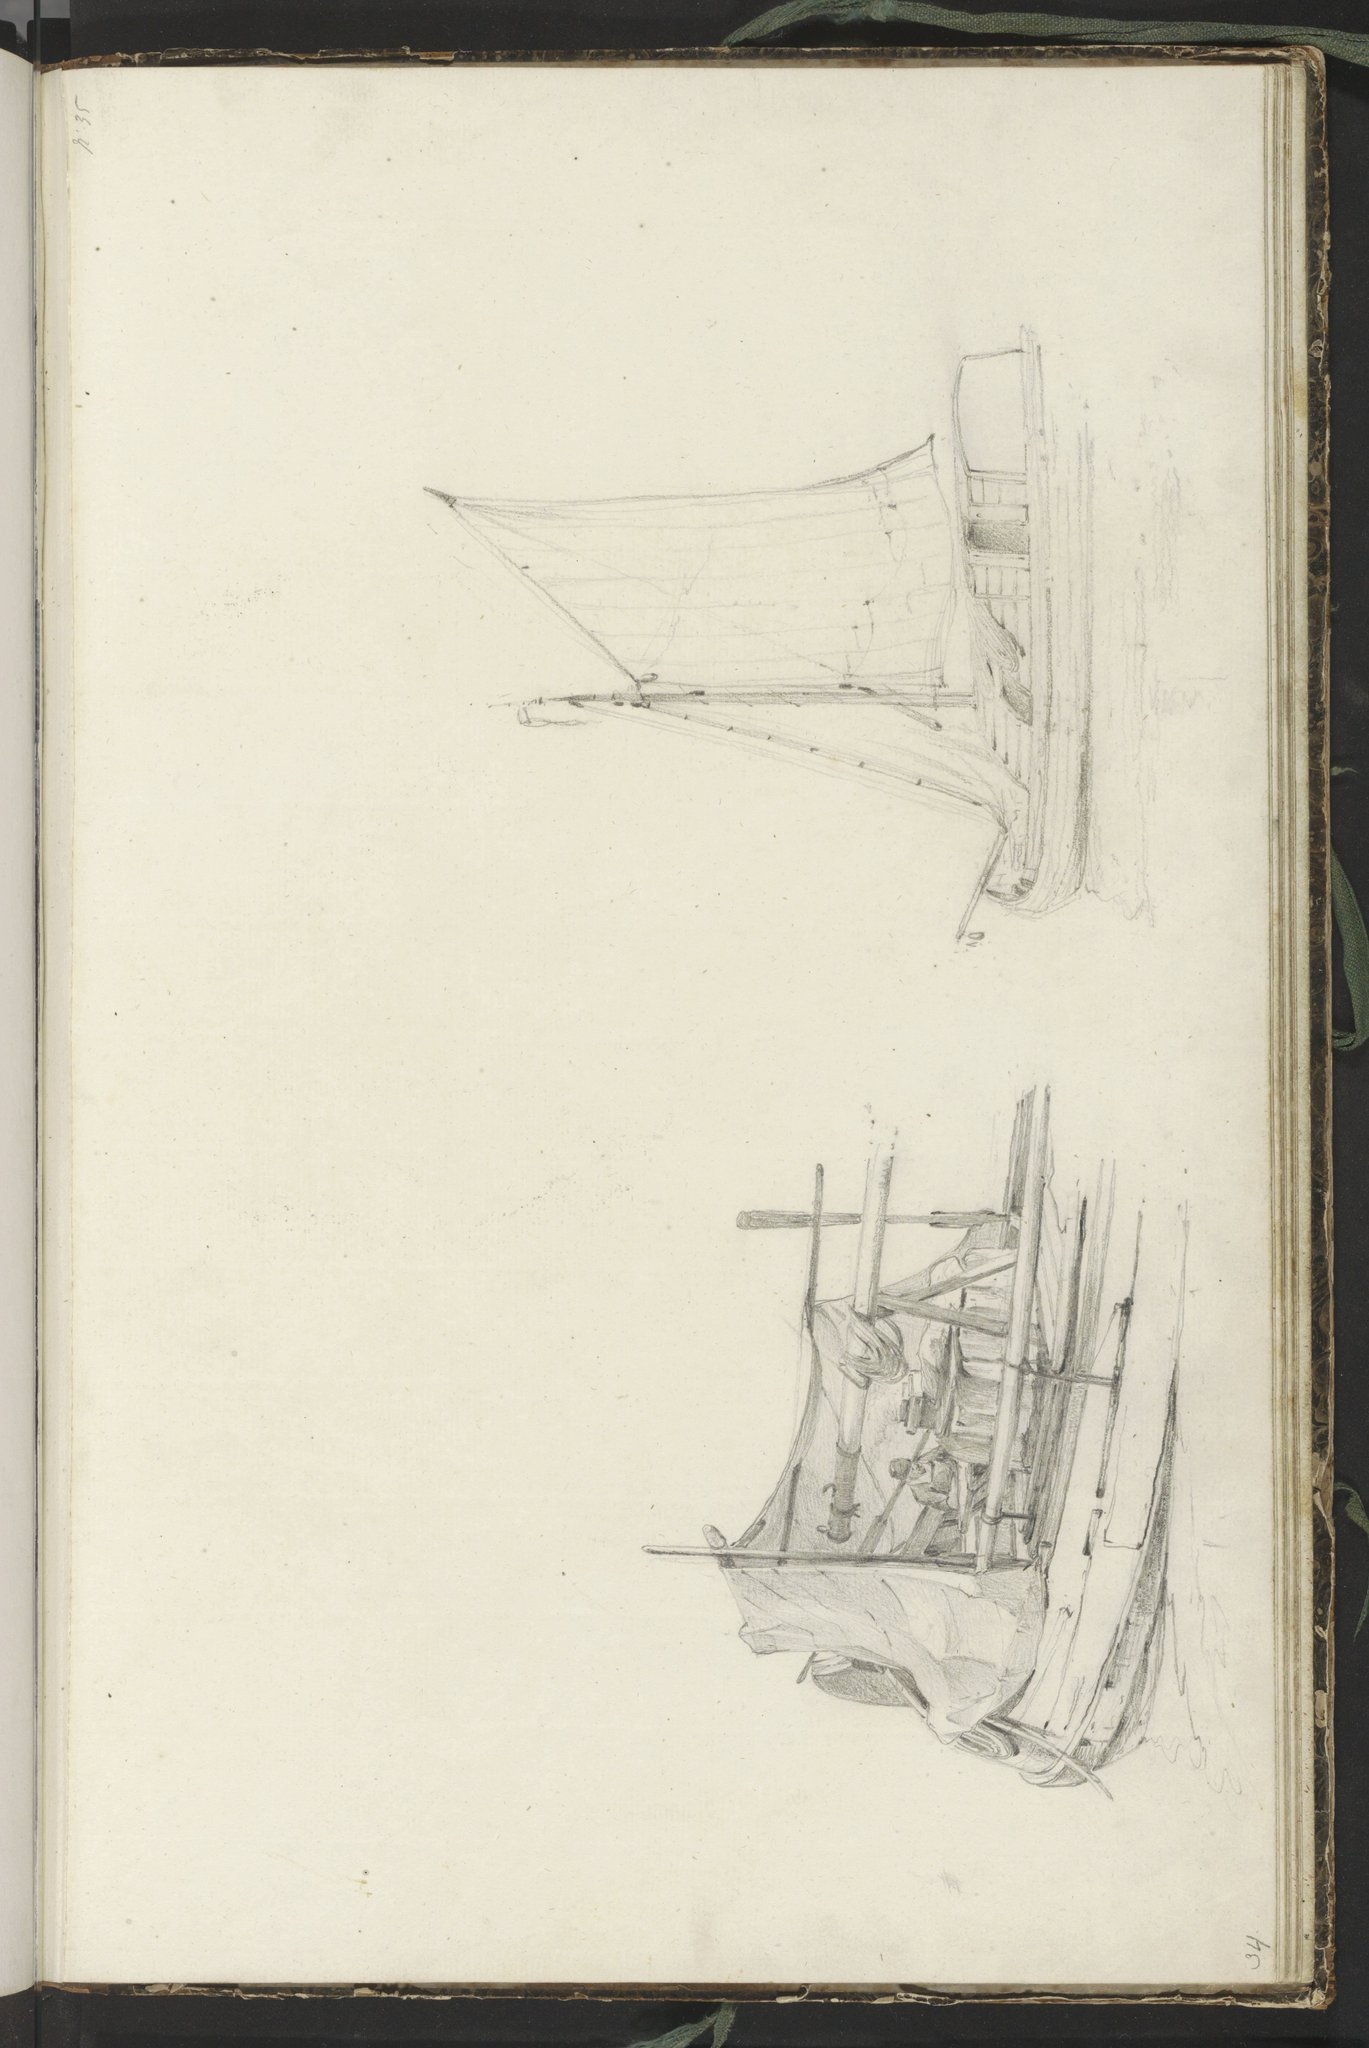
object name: sketchbook leaf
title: Twee zeilschepen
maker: johannes christiaan schotel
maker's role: draughtsman, painter, print maker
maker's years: 1787-1838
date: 1797-1838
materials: chalk, paper, pencil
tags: sailing-ship, sailing-boat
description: Op het ene zeilschip zit een figuur in een hoek half onder het gestreken zeil. Op het andere zeilschip is het zeil gehesen. Blad 34 recto uit een schetsboek met 44 bladen.